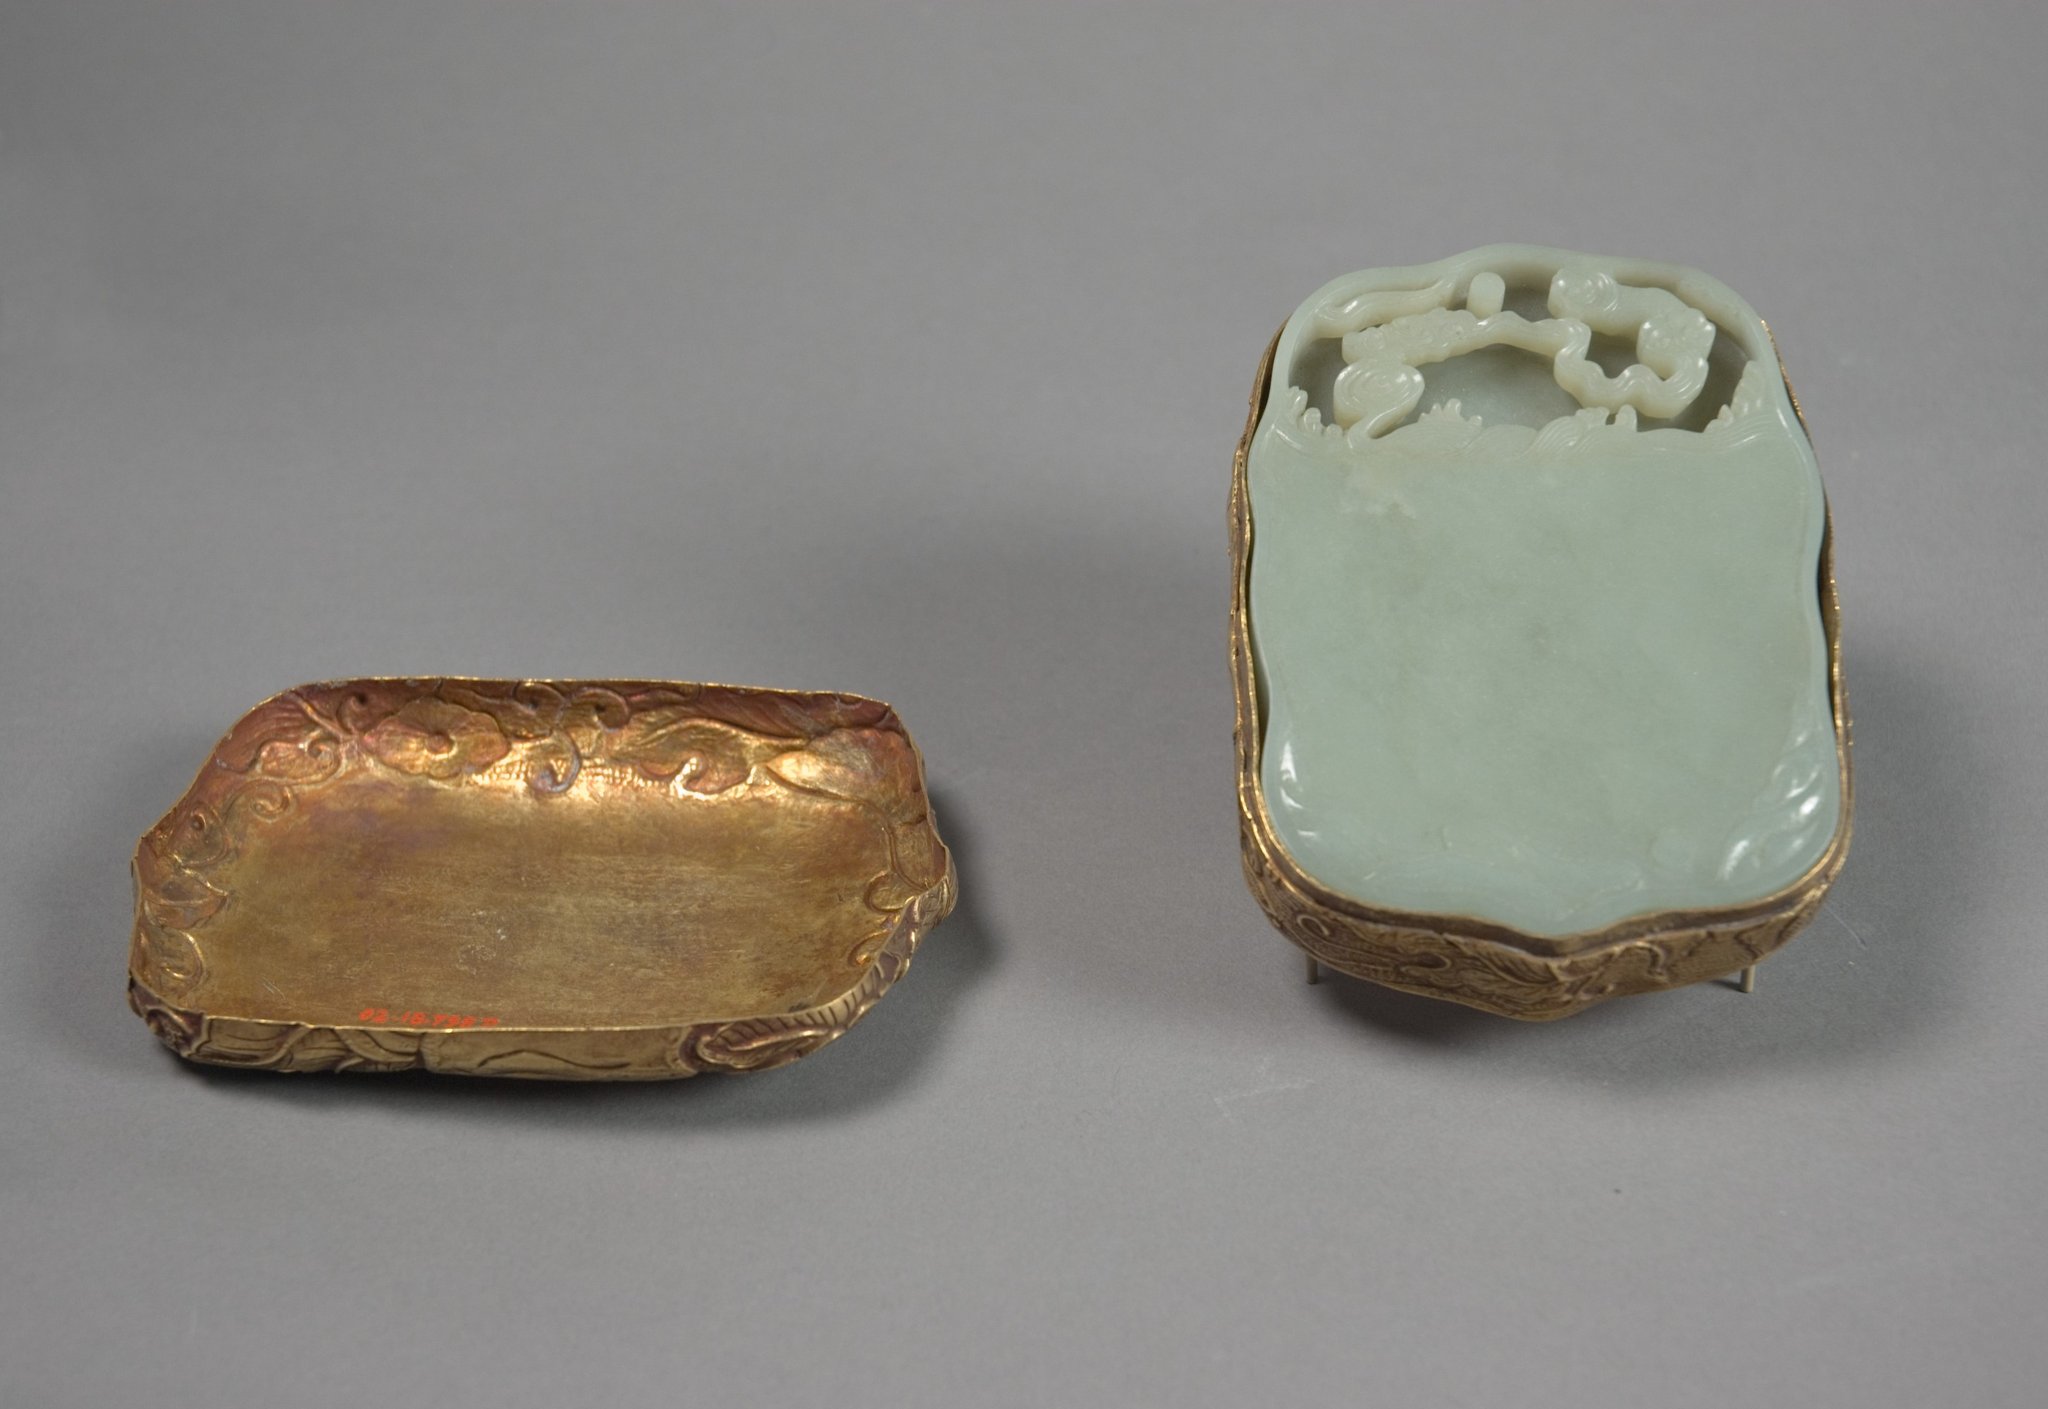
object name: ink palette and horn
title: Ink palette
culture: chinese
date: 1801-1900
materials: jade, silver